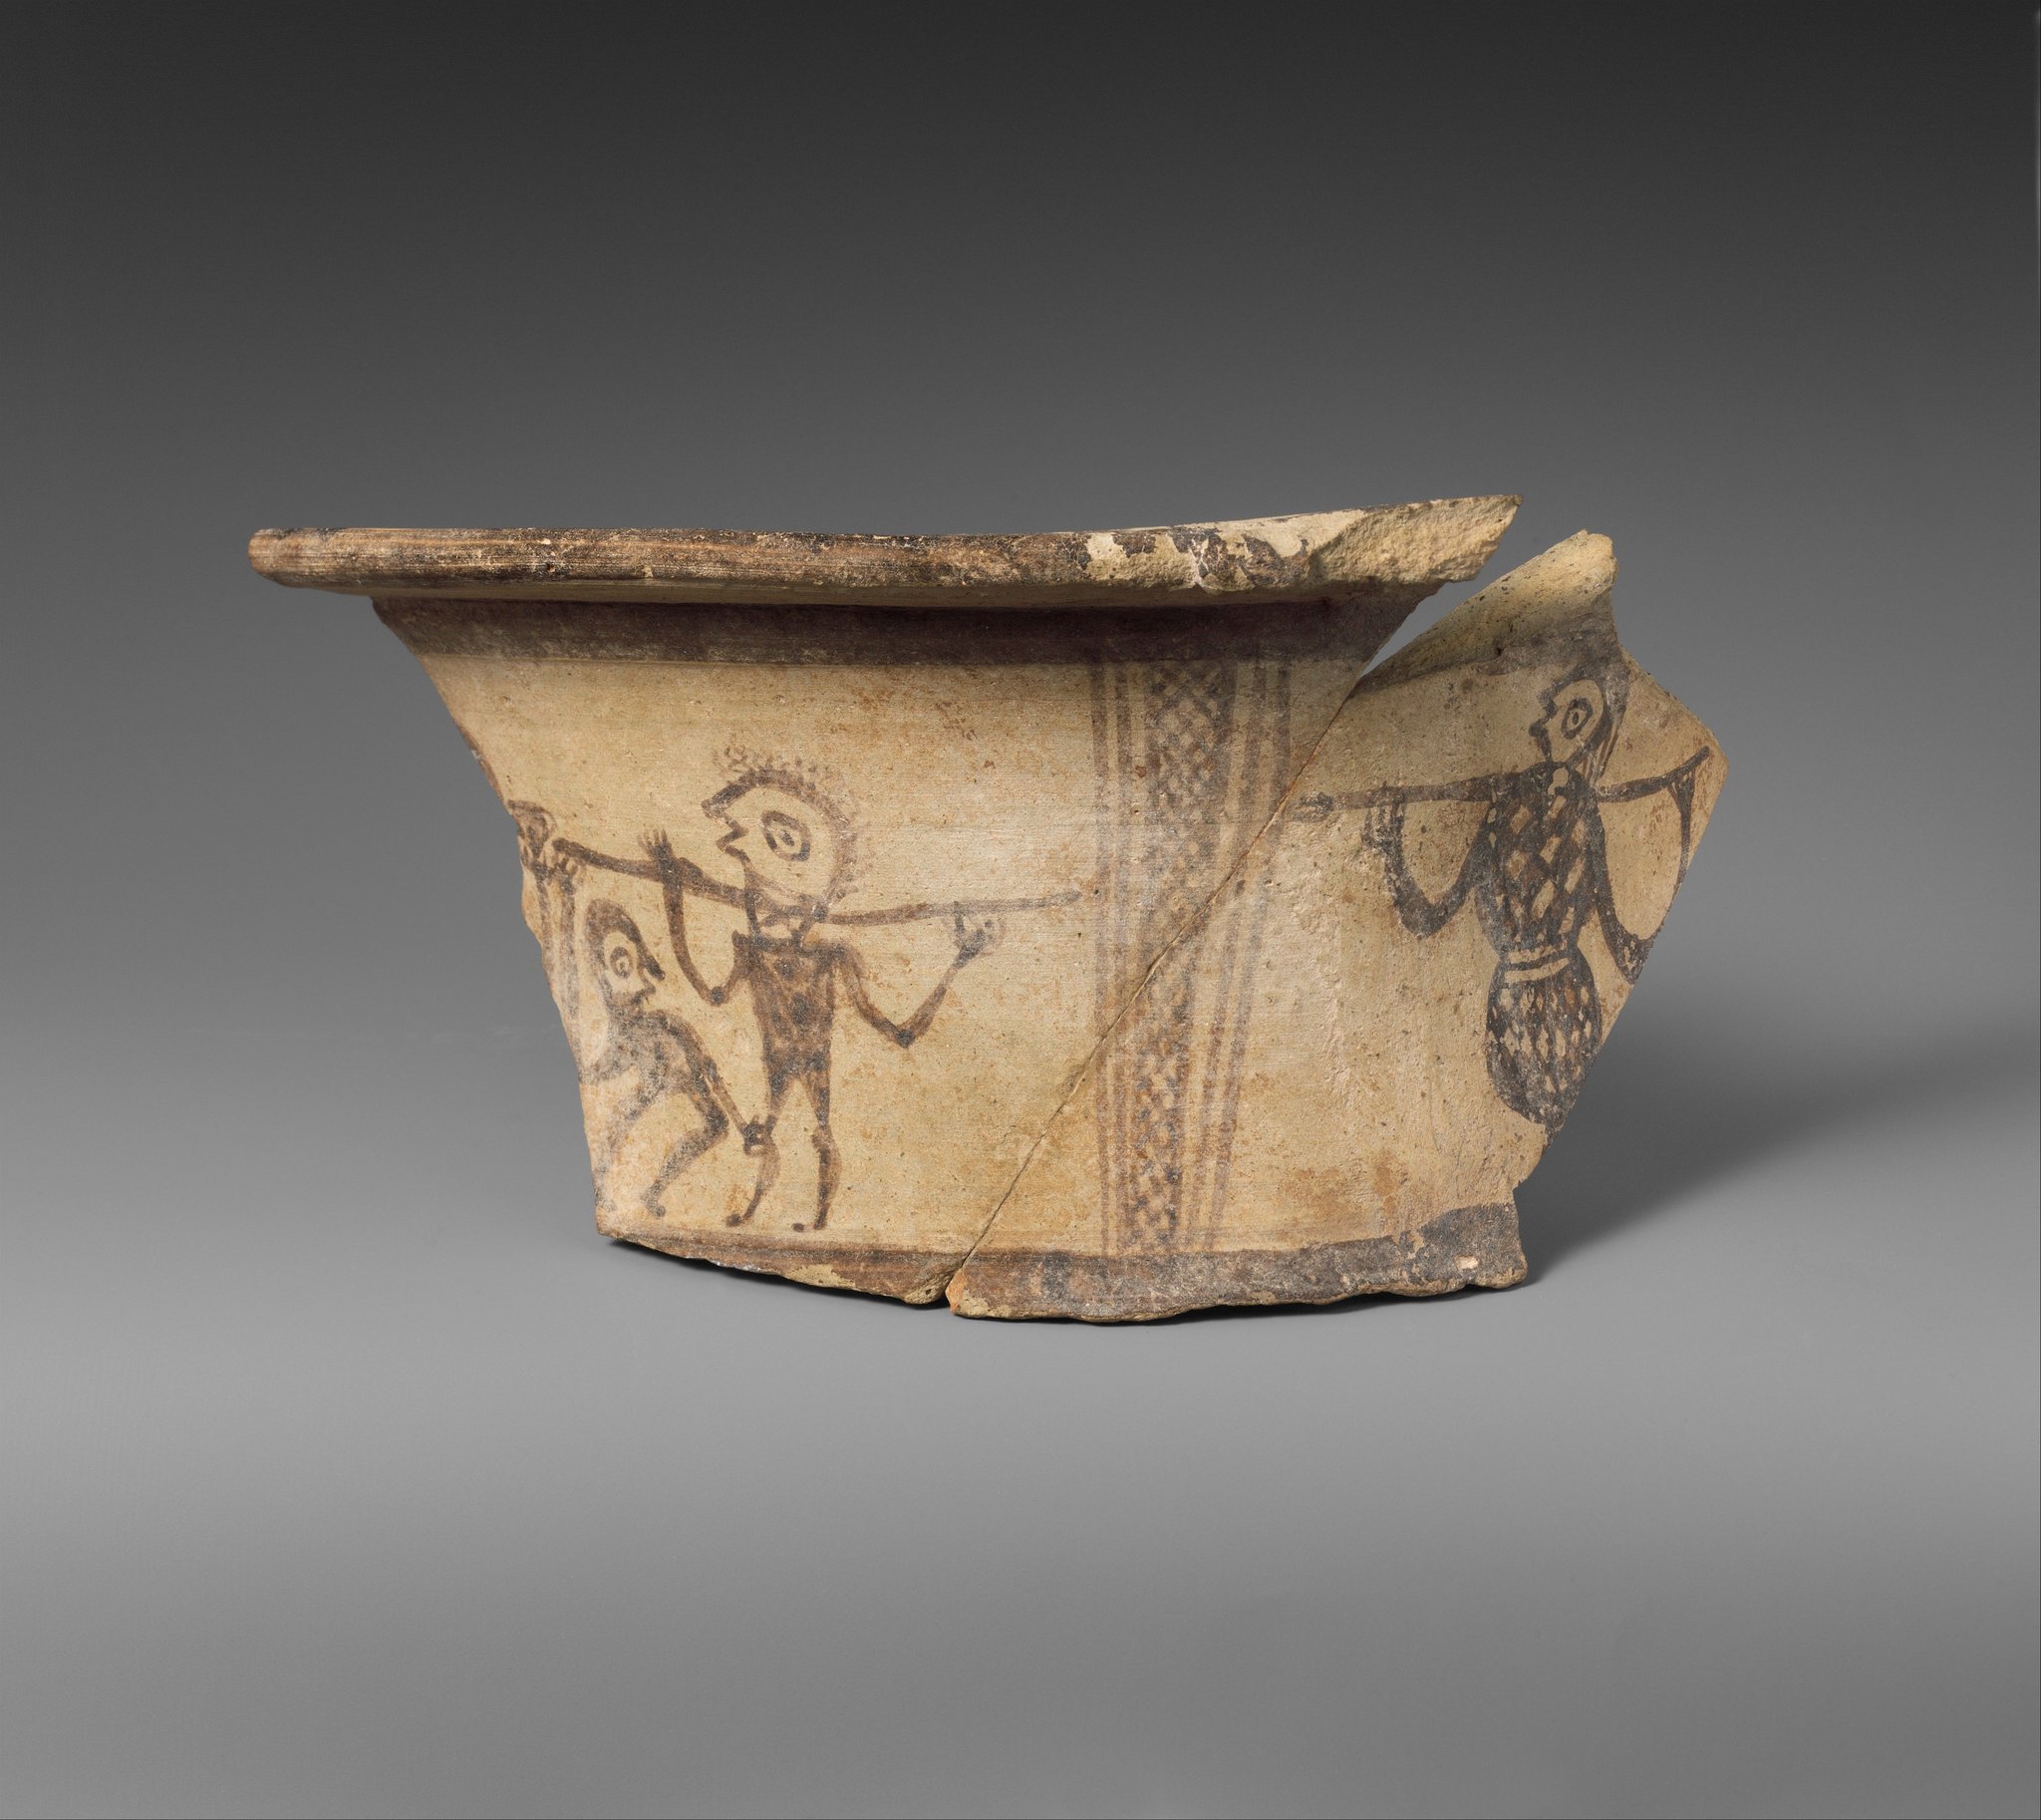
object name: amphora fragment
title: Fragment from the neck of a terracotta amphora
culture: cypriot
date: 850-750 BCE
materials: terracotta